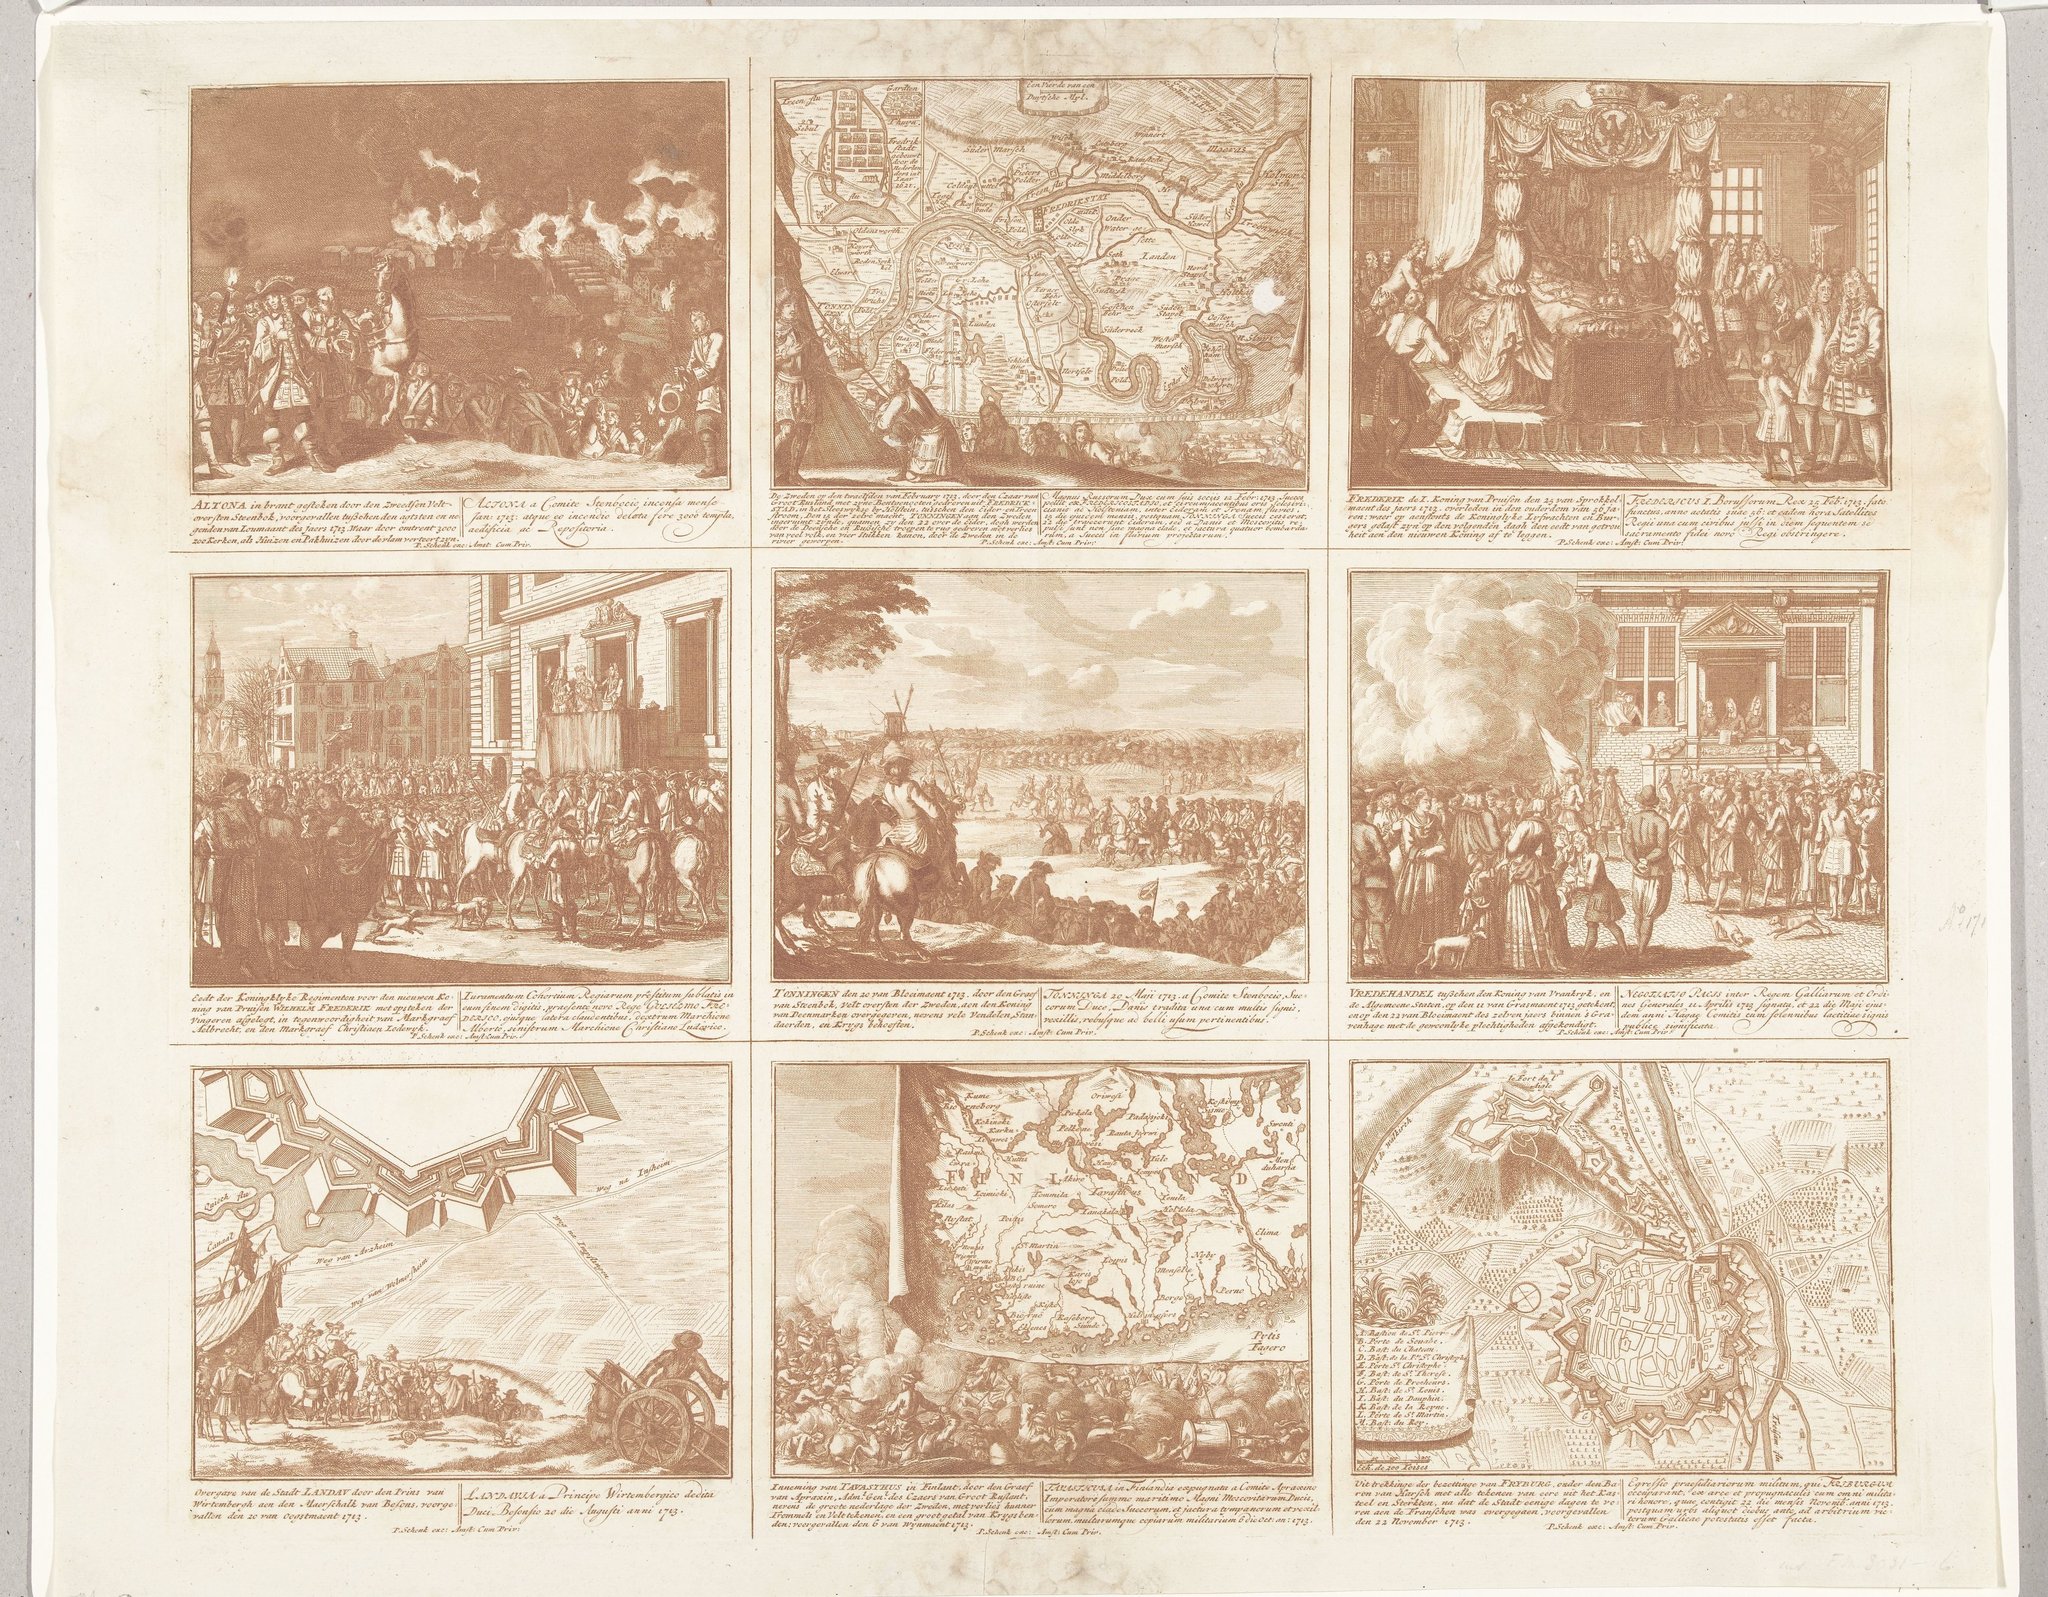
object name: print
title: Blad met negen voorstellingen van gebeurtenissen in het jaar 1713 van de Spaanse Successieoorlog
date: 1713-1720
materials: paper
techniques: engraving, etching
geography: amsterdam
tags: spaanse successieoorlog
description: Blad met negen voorstellingen van gebeurtenissen uit het jaar 1713 tijdens de Spaanse Successieoorlog. Verschillende kaarten, plattegronden en oorlogstaferelen. Elke voorstelling met een onderschrift in het Nederlands en Latijn. Plaat XIV in een reeks van platen uitgegeven onder de titel: Schouwburg van den oorlog / Theatrum Bellicum.